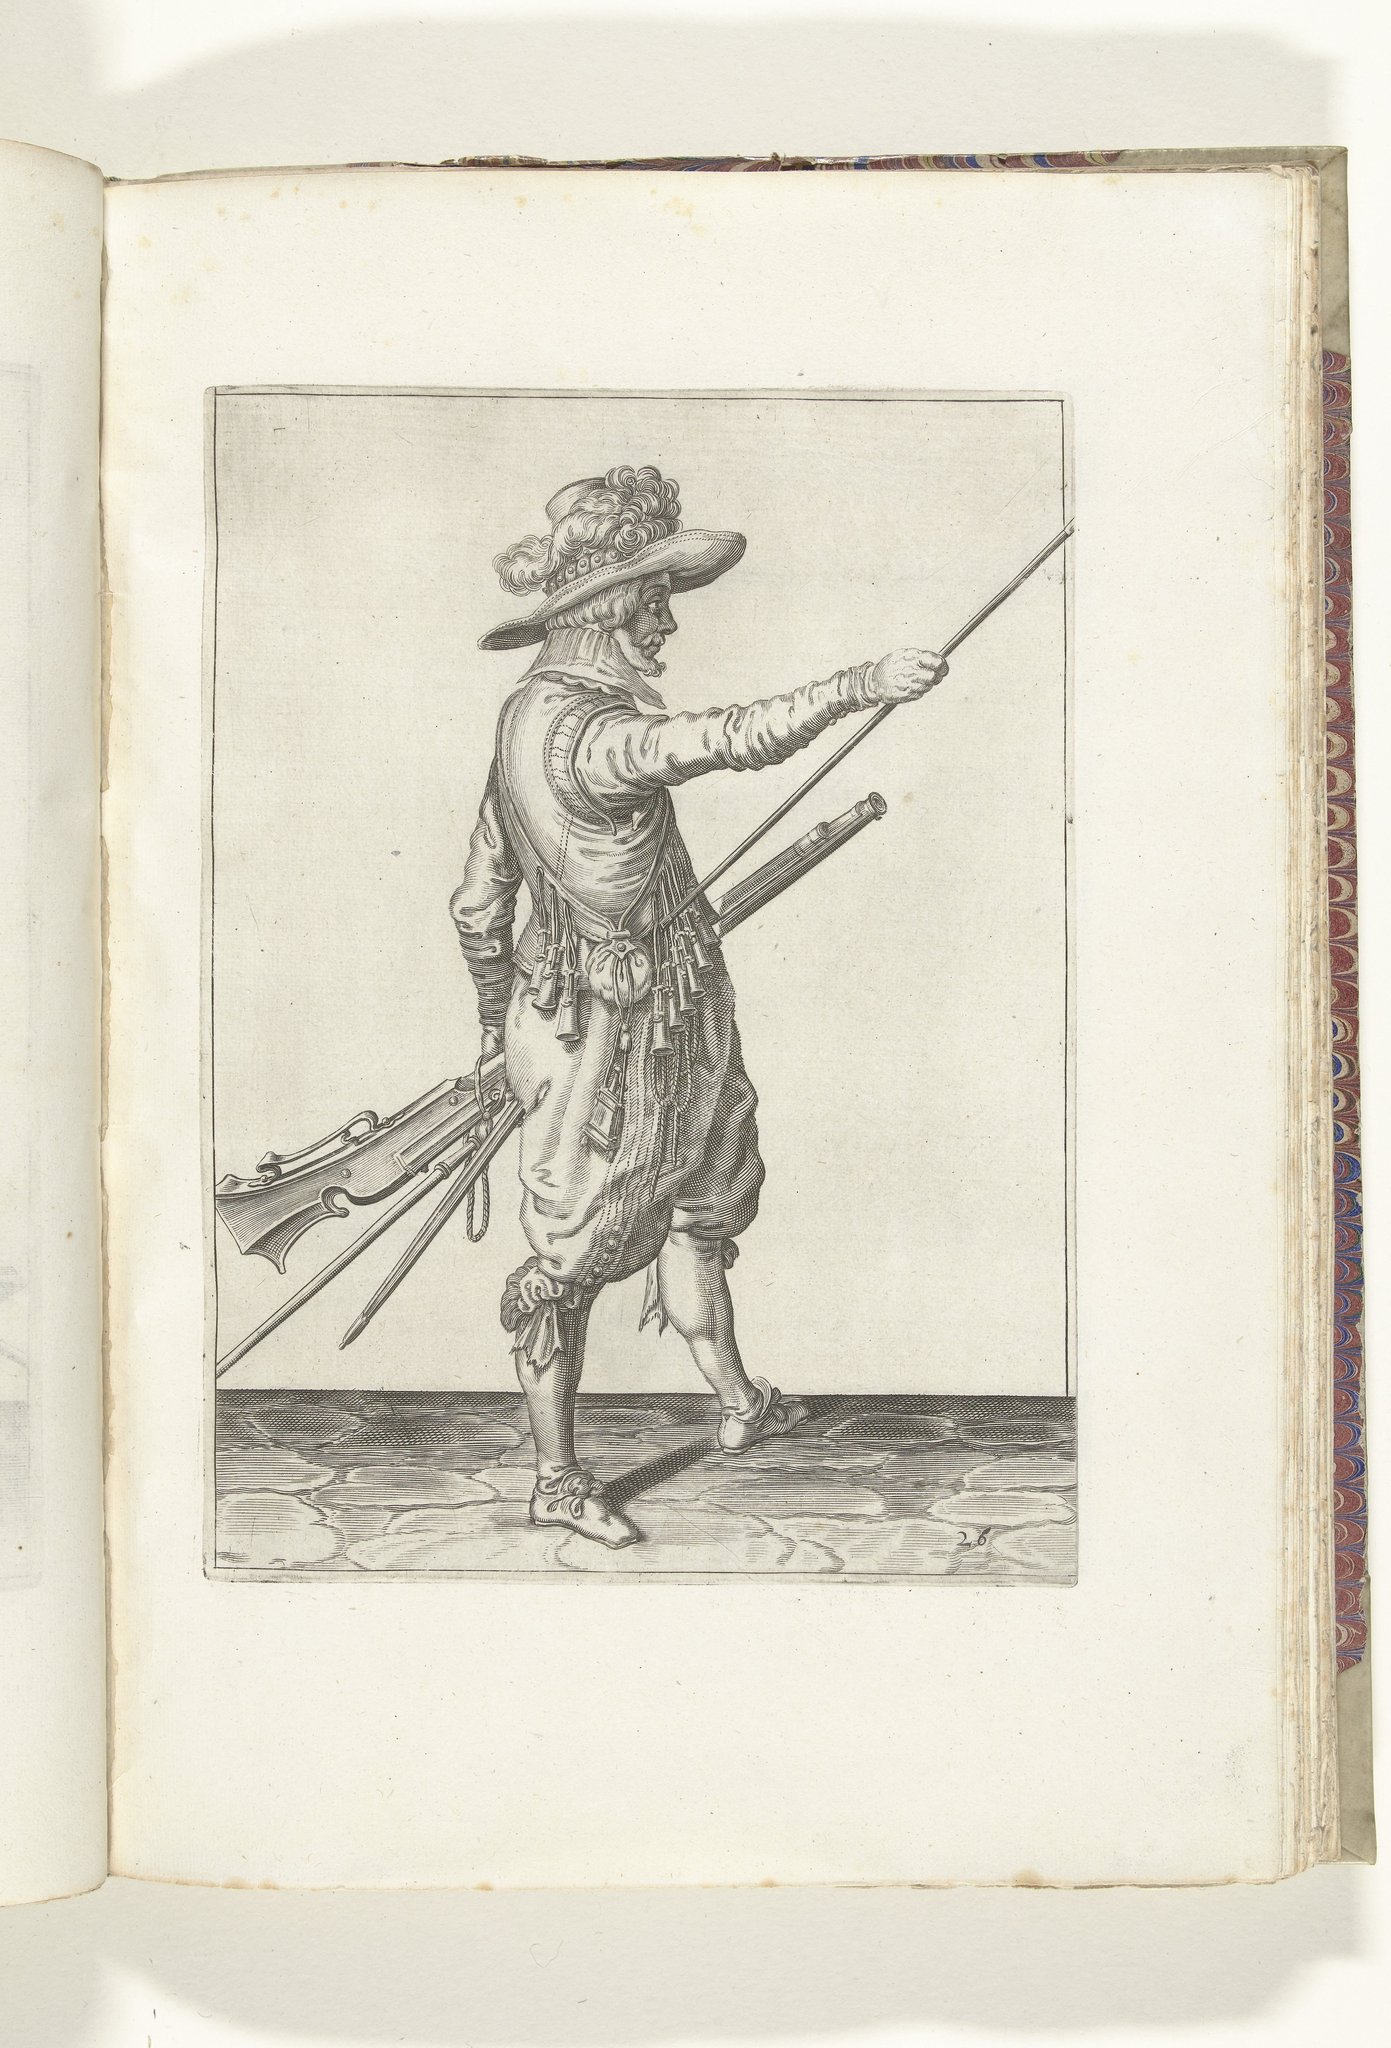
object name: print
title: Soldaat met een musket die zijn rechterhand naar het uiteinde van zijn laadstok schuift (nr. 26), ca. 1600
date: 1597-1607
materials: paper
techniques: engraving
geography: amsterdam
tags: the hague, maurice (prince of orange), handling of weapons ~ military training, weapons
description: Een soldaat, ten voeten uit, naar rechts, die met zijn linkerhand bij zijn linkerdijbeen een musket (een bepaald type vuurwapen) vasthoudt en zijn rechterhand naar het uiteinde brengt van zijn laadstok, die hij tegen zijn rechterzij laat steunen (nr. 26), ca. 1600. In zijn linkerhand behalve het musket ook een lont; aan zijn linkerpols een furket (musketvork). Plaat 26 in de instructies voor het hanteren van het musket: Corte onderrechtinghe op de figuerlicke afbeeldinghe, soo veel aengaet het recht ghebruyck van Musquet. Onderdeel van de illustraties in: J. de Gheyn, Wapenhandelinghe van Roers Musquetten ende spiessen, Amsterdam, 1608. Krijgswezen rond 1600.